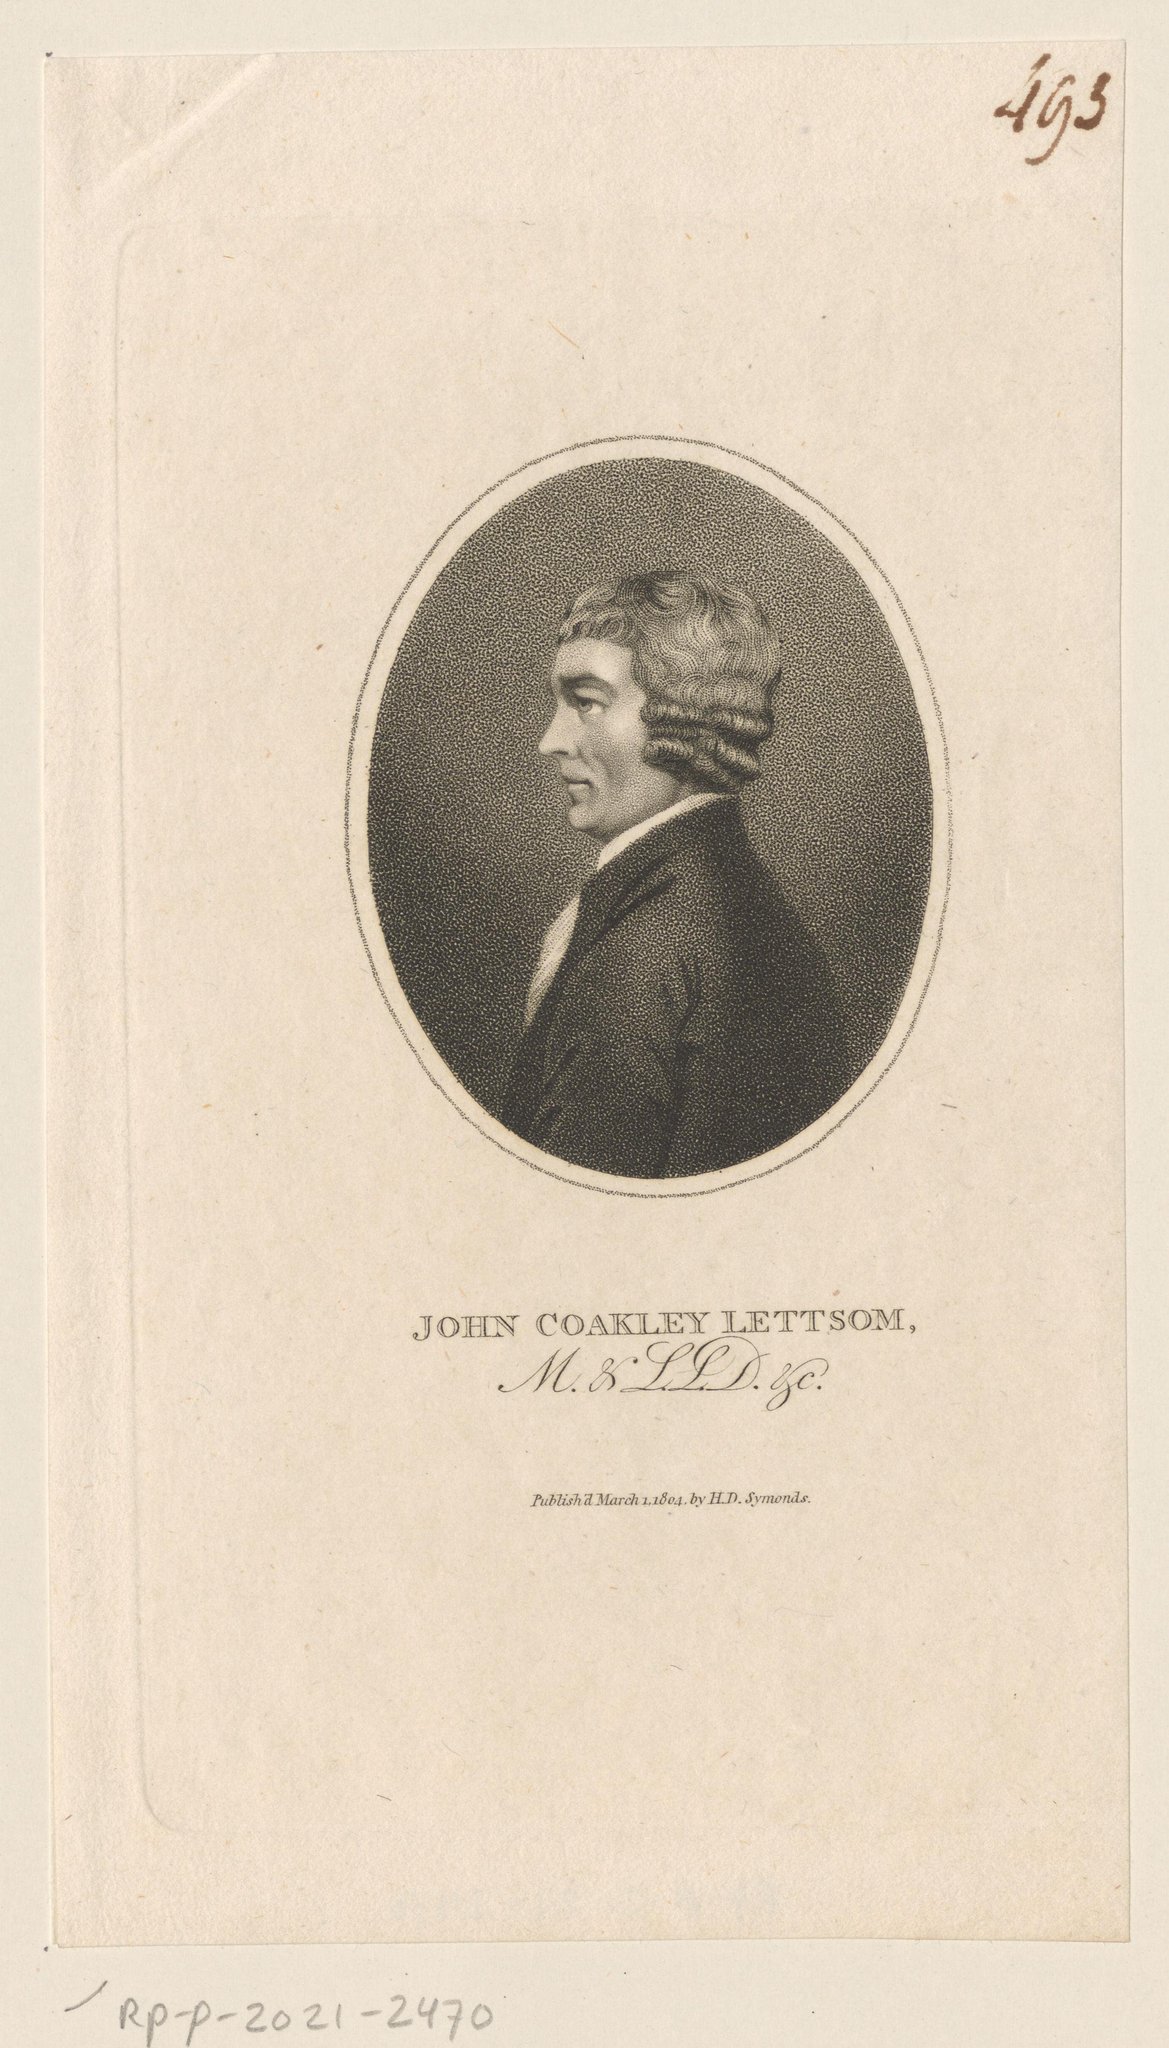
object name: print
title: Portret van John Coakley Lettsom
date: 1804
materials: paper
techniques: stippling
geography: london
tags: historical persons, physician, doctor (+ portrait of scholar, scientist)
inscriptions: number: ‘493’